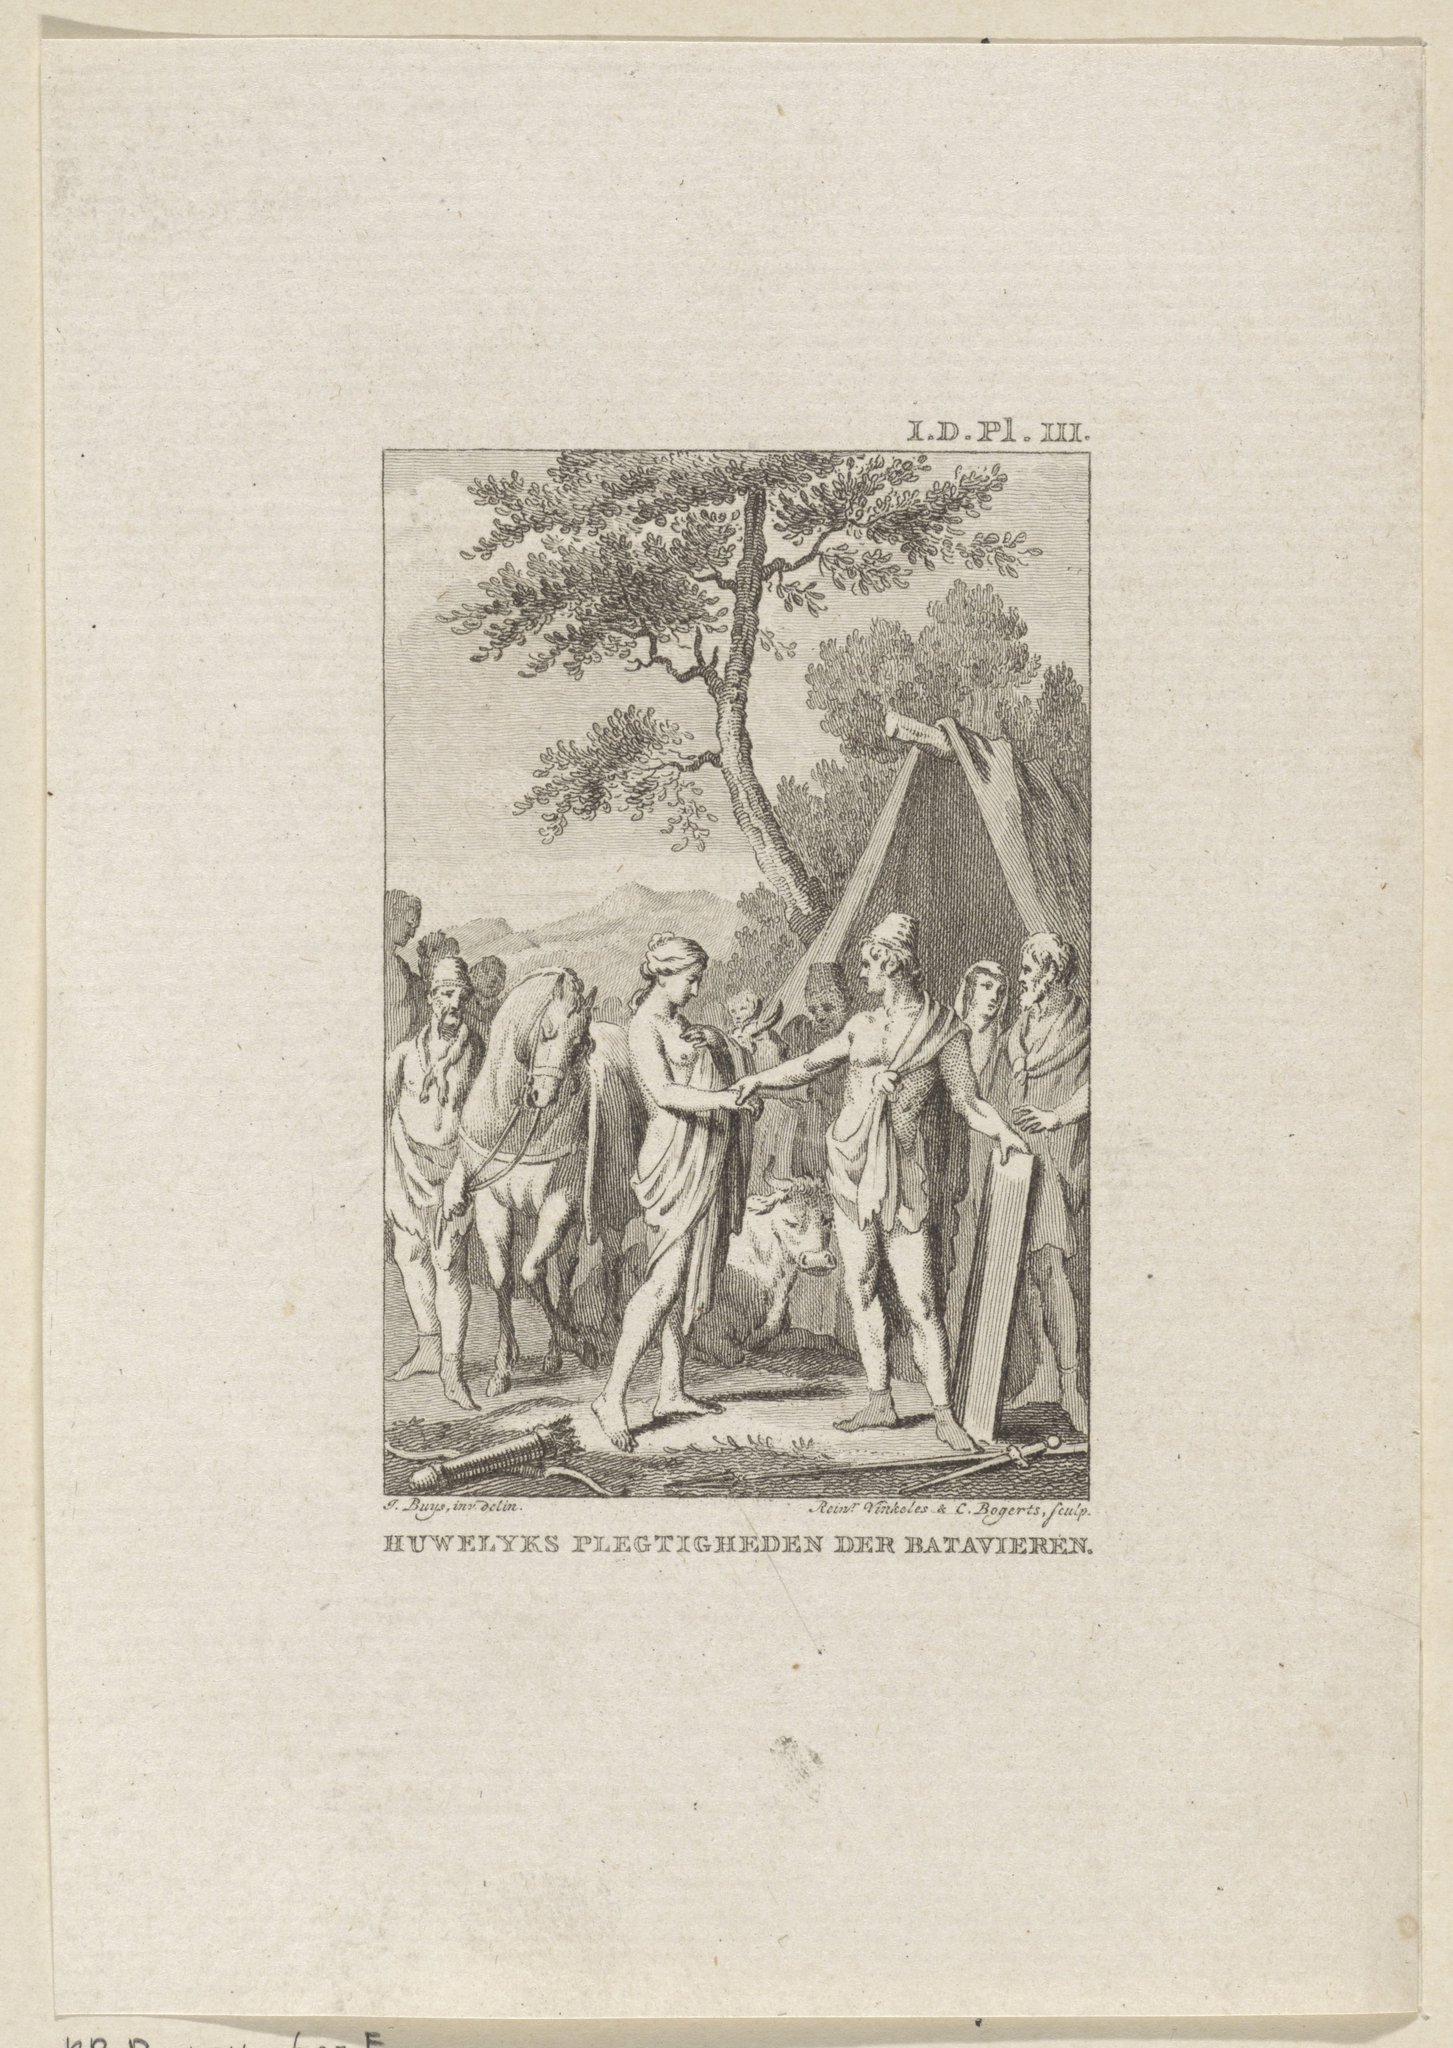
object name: print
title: Huwelyks plegtigheden der Batavieren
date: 1783-1795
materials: paper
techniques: etching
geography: amsterdam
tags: civil marriage ceremony (+ variant), extinct, 'historical' peoples (with name)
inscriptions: collector's mark: Lugt 2228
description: Illustratie voor: J. Fokke. Geschiedenissen der Vereenigde Nederlanden voor de vaderlandsche jeugd. Amsterdam: Johannes Allart, 1783-1795, 25 delen, dl. I, pl. III.